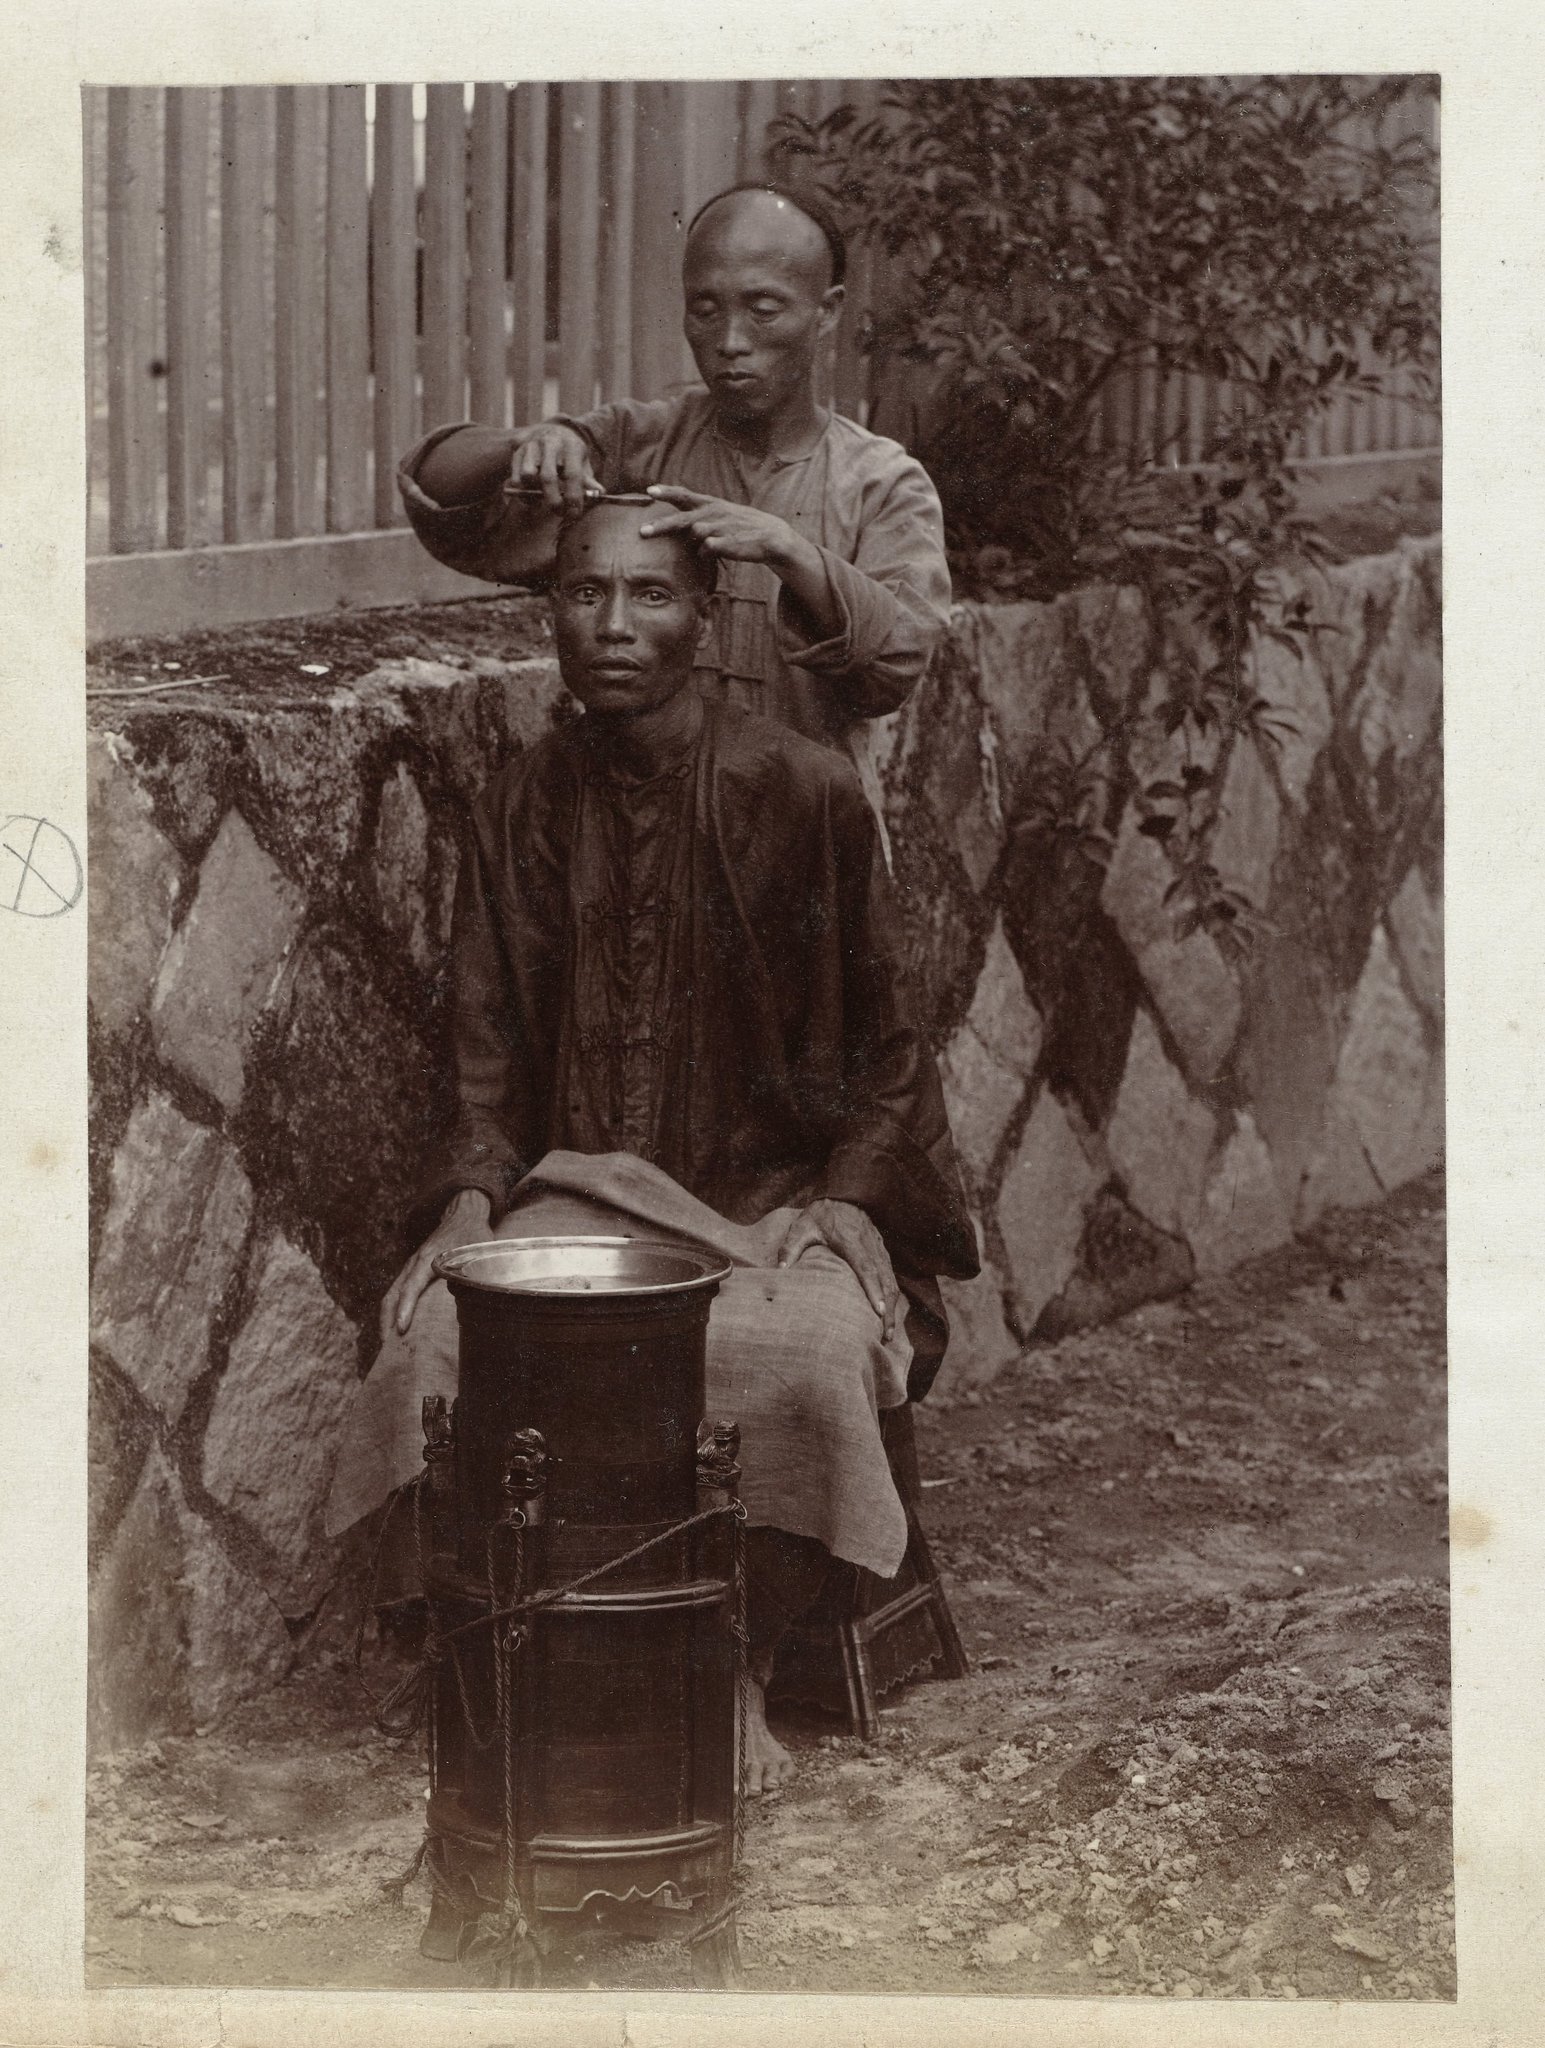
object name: photograph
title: Chinese kapper scheert een klant op straat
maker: Anonymous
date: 1879-1890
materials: paper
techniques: albumen print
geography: china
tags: shaven head, shaving, being shaved, barber, barbershop, china